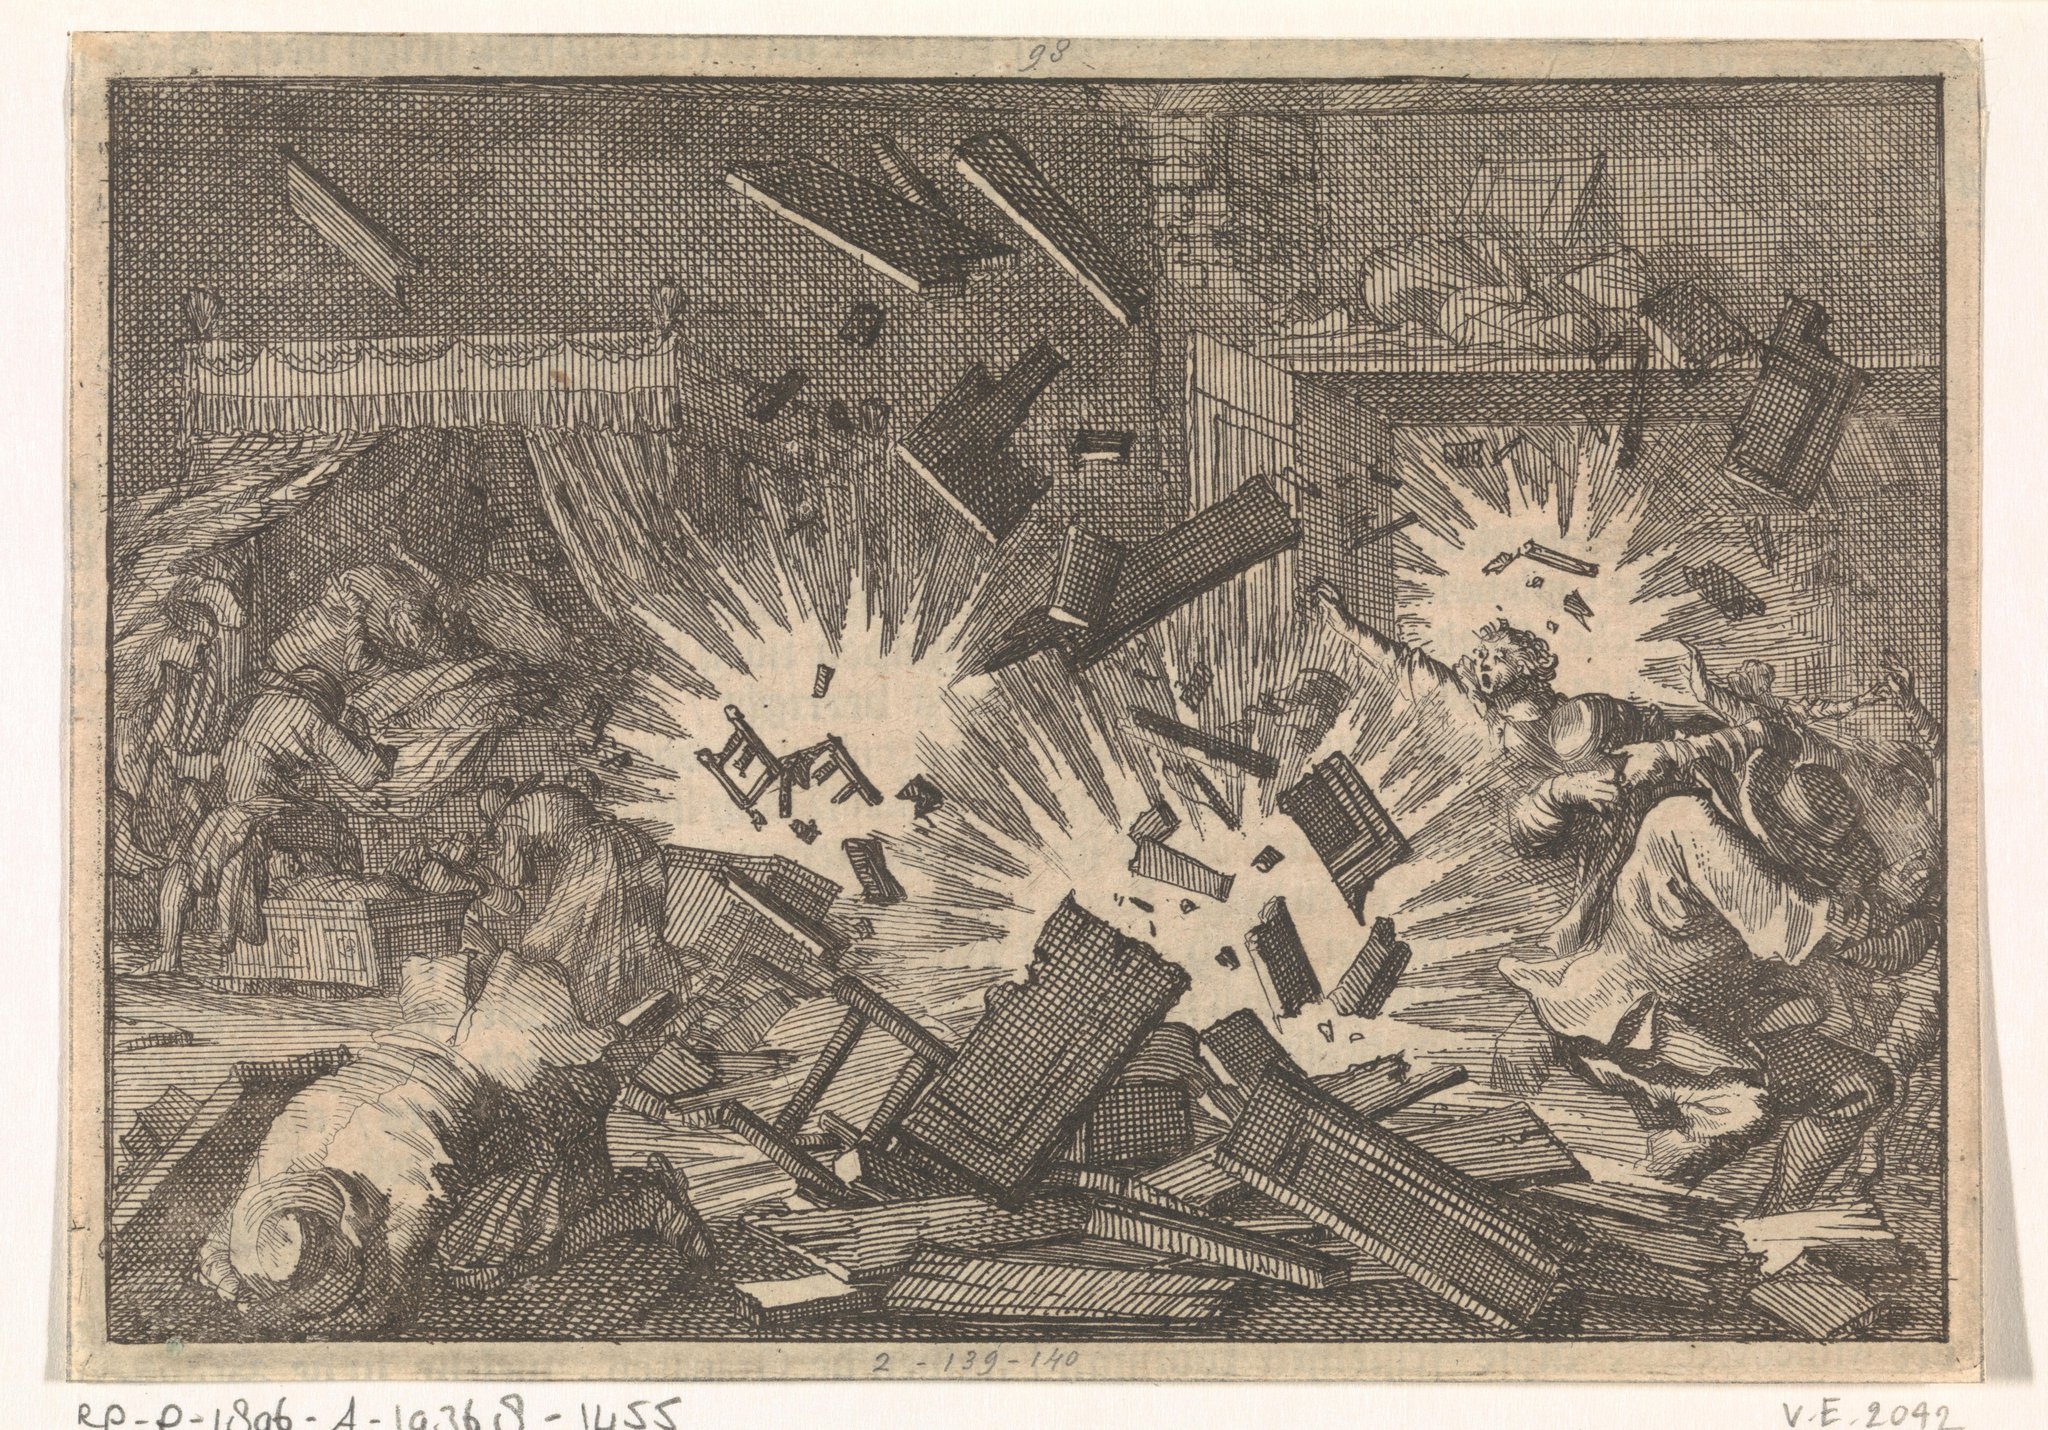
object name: book illustration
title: Tijdens het beleg van Riga ontploft een bom in een woning, 1656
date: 1698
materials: paper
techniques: etching, letterpress printing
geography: leiden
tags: interior of the house, siege, gunpowder disaster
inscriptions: collector's mark: Lugt 2228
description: Illustratie uit: Gottfried, Johann Ludwig. Historische kronyck; vervattende een (...) beschrijvingh der aldergedenckwaerdigste geschiedenissen des weerelds, van den aenvangh der scheppingh tot (...) 1576 (2 delen). Leiden: Pieter van der Aa, 1698, dl. II, p. 139.